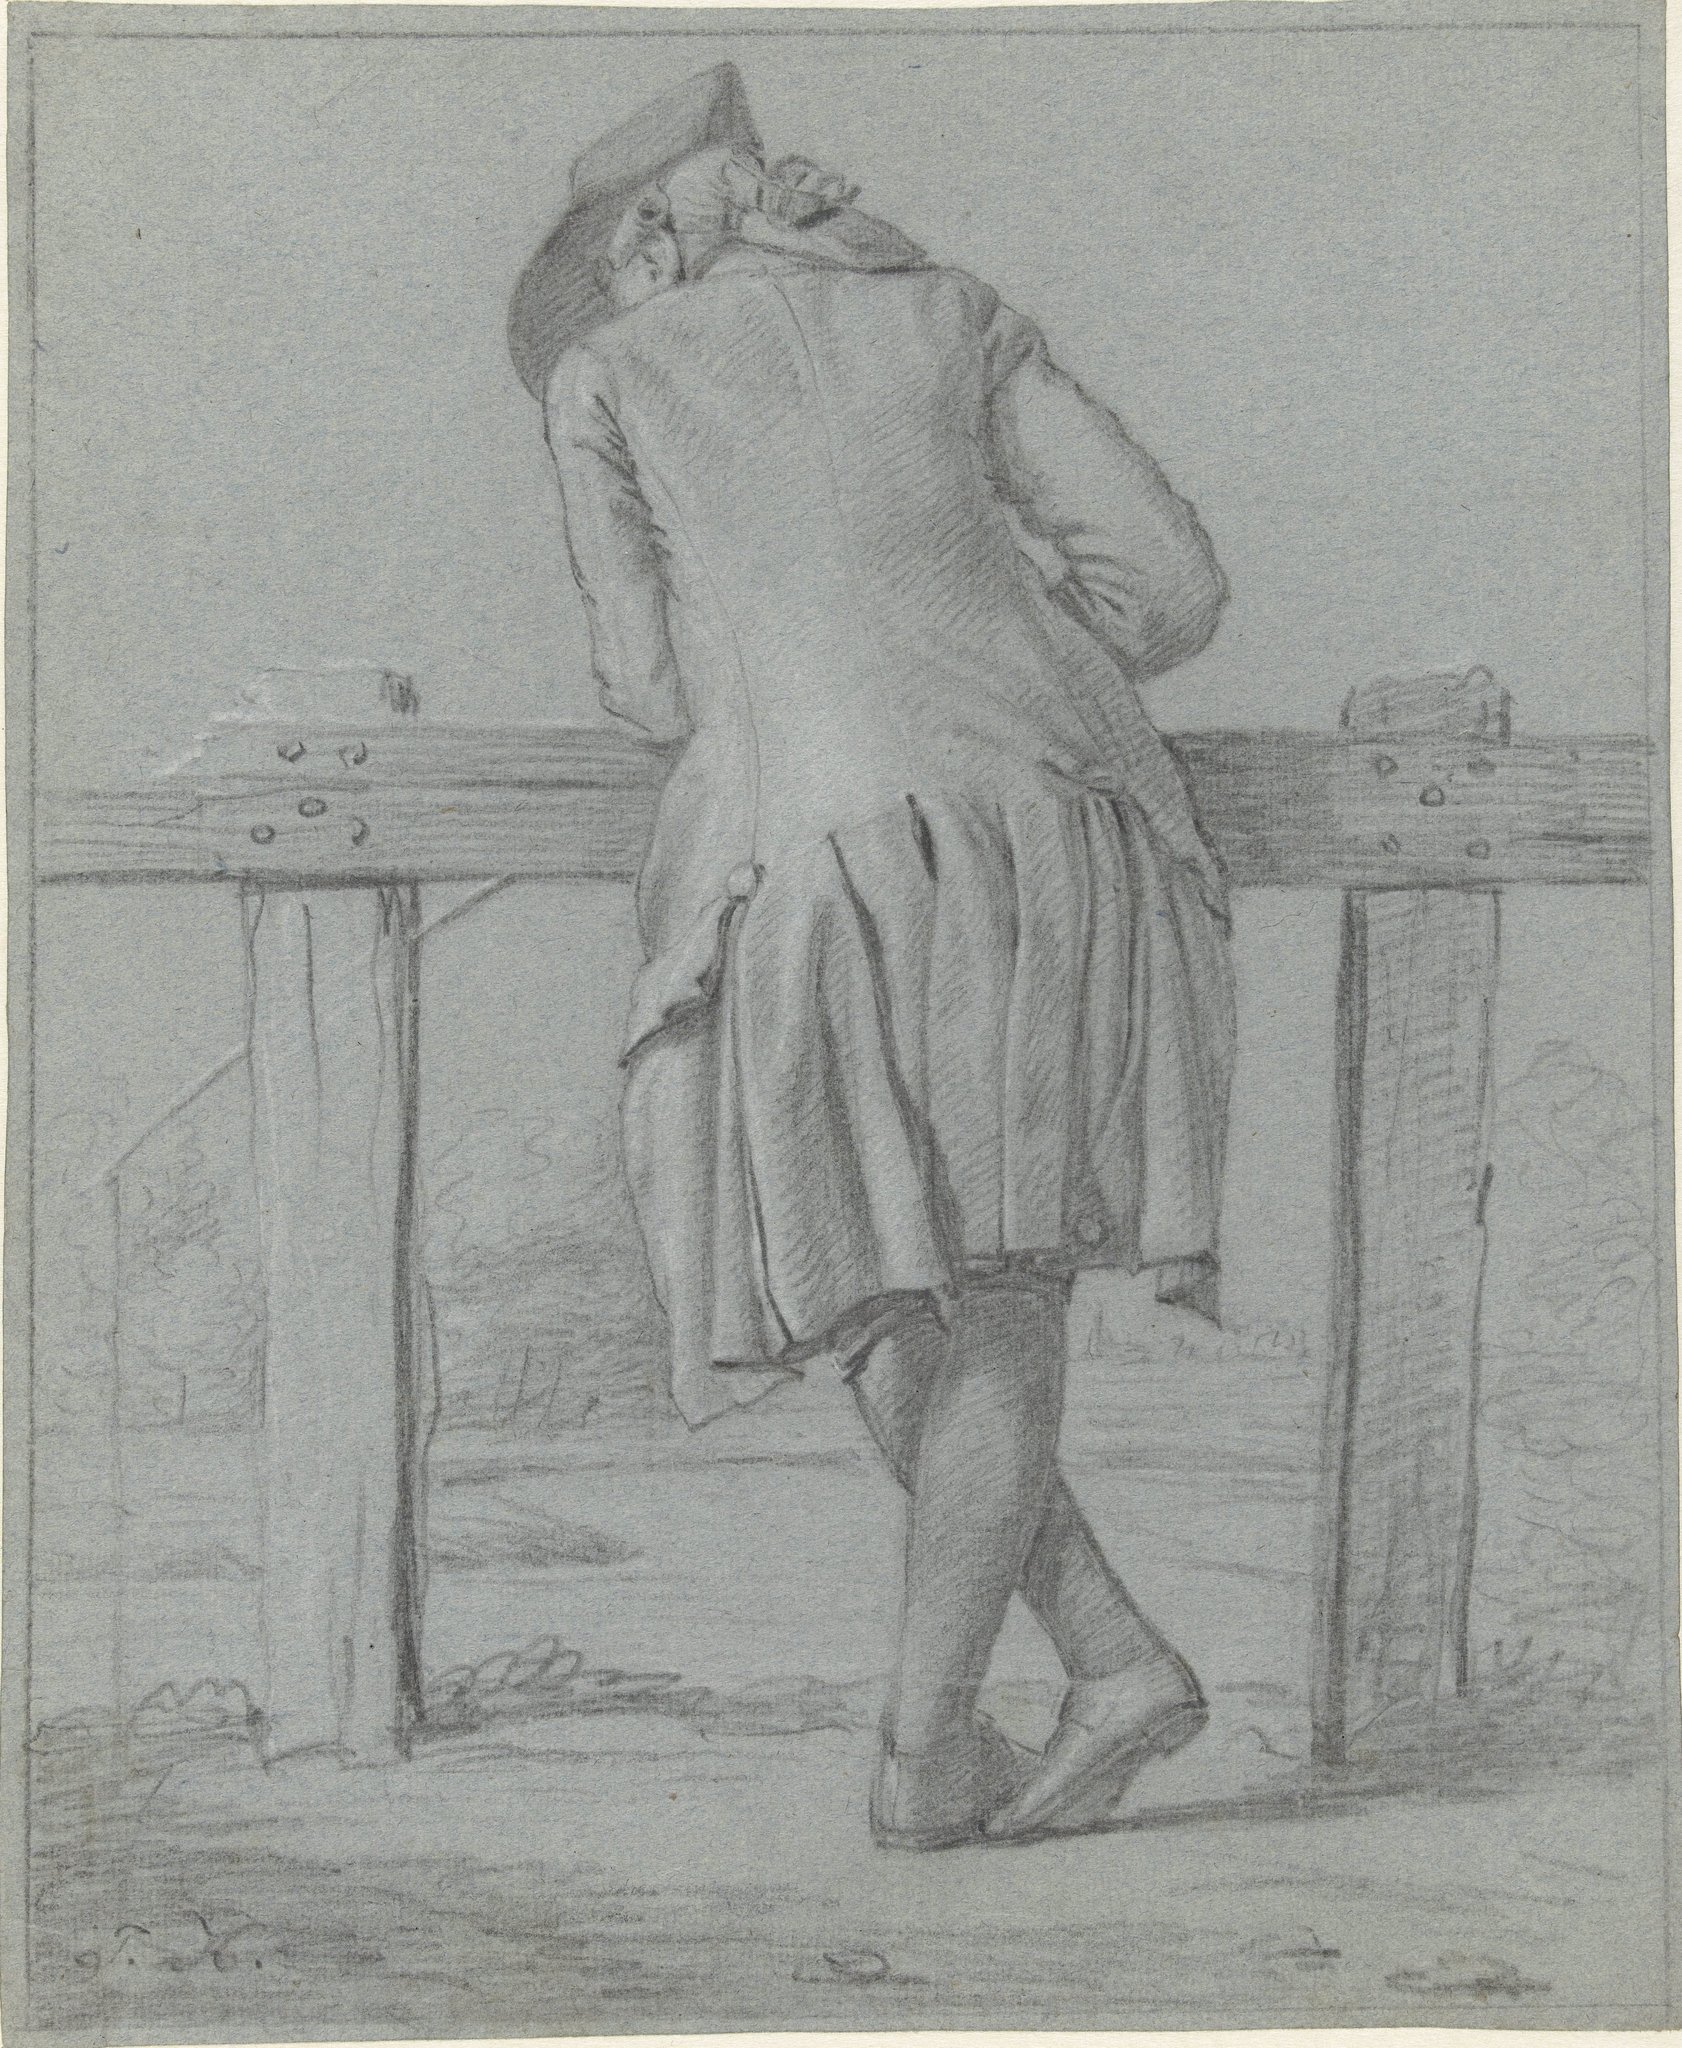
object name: drawing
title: Staande heer, op de rug gezien, leunend over een hek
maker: jordanus hoorn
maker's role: draughtsman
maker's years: 1753-1833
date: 1763-1833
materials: chalk, paper